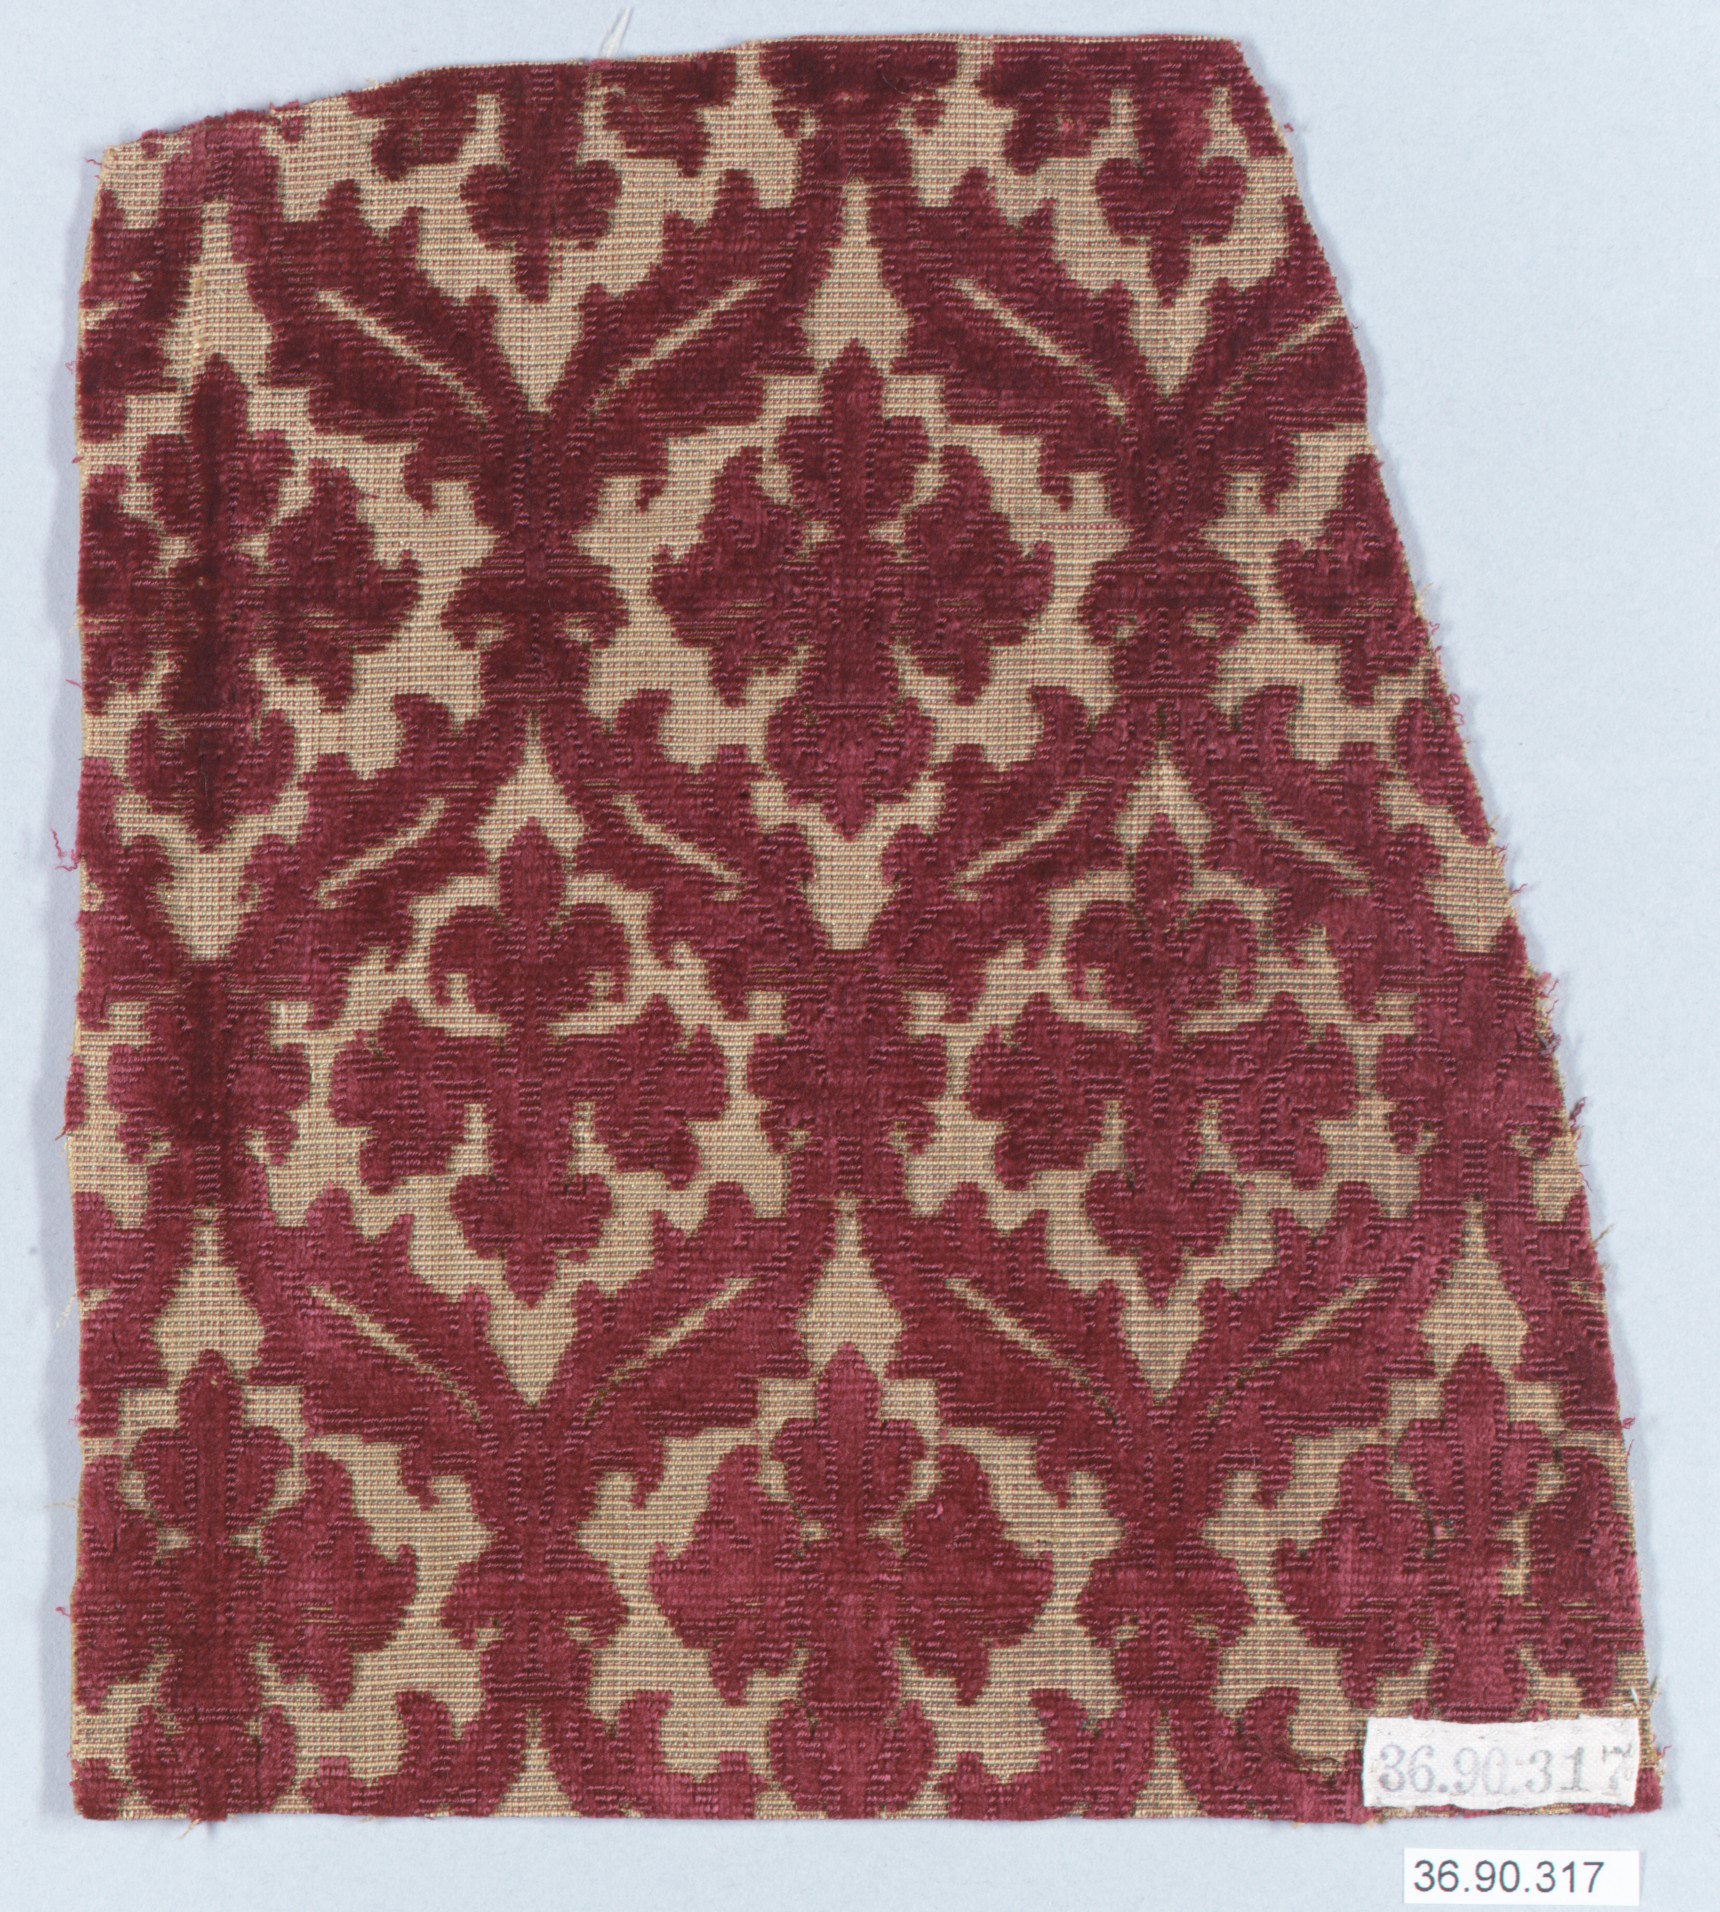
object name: piece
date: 1501-1700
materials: metal thread, silk